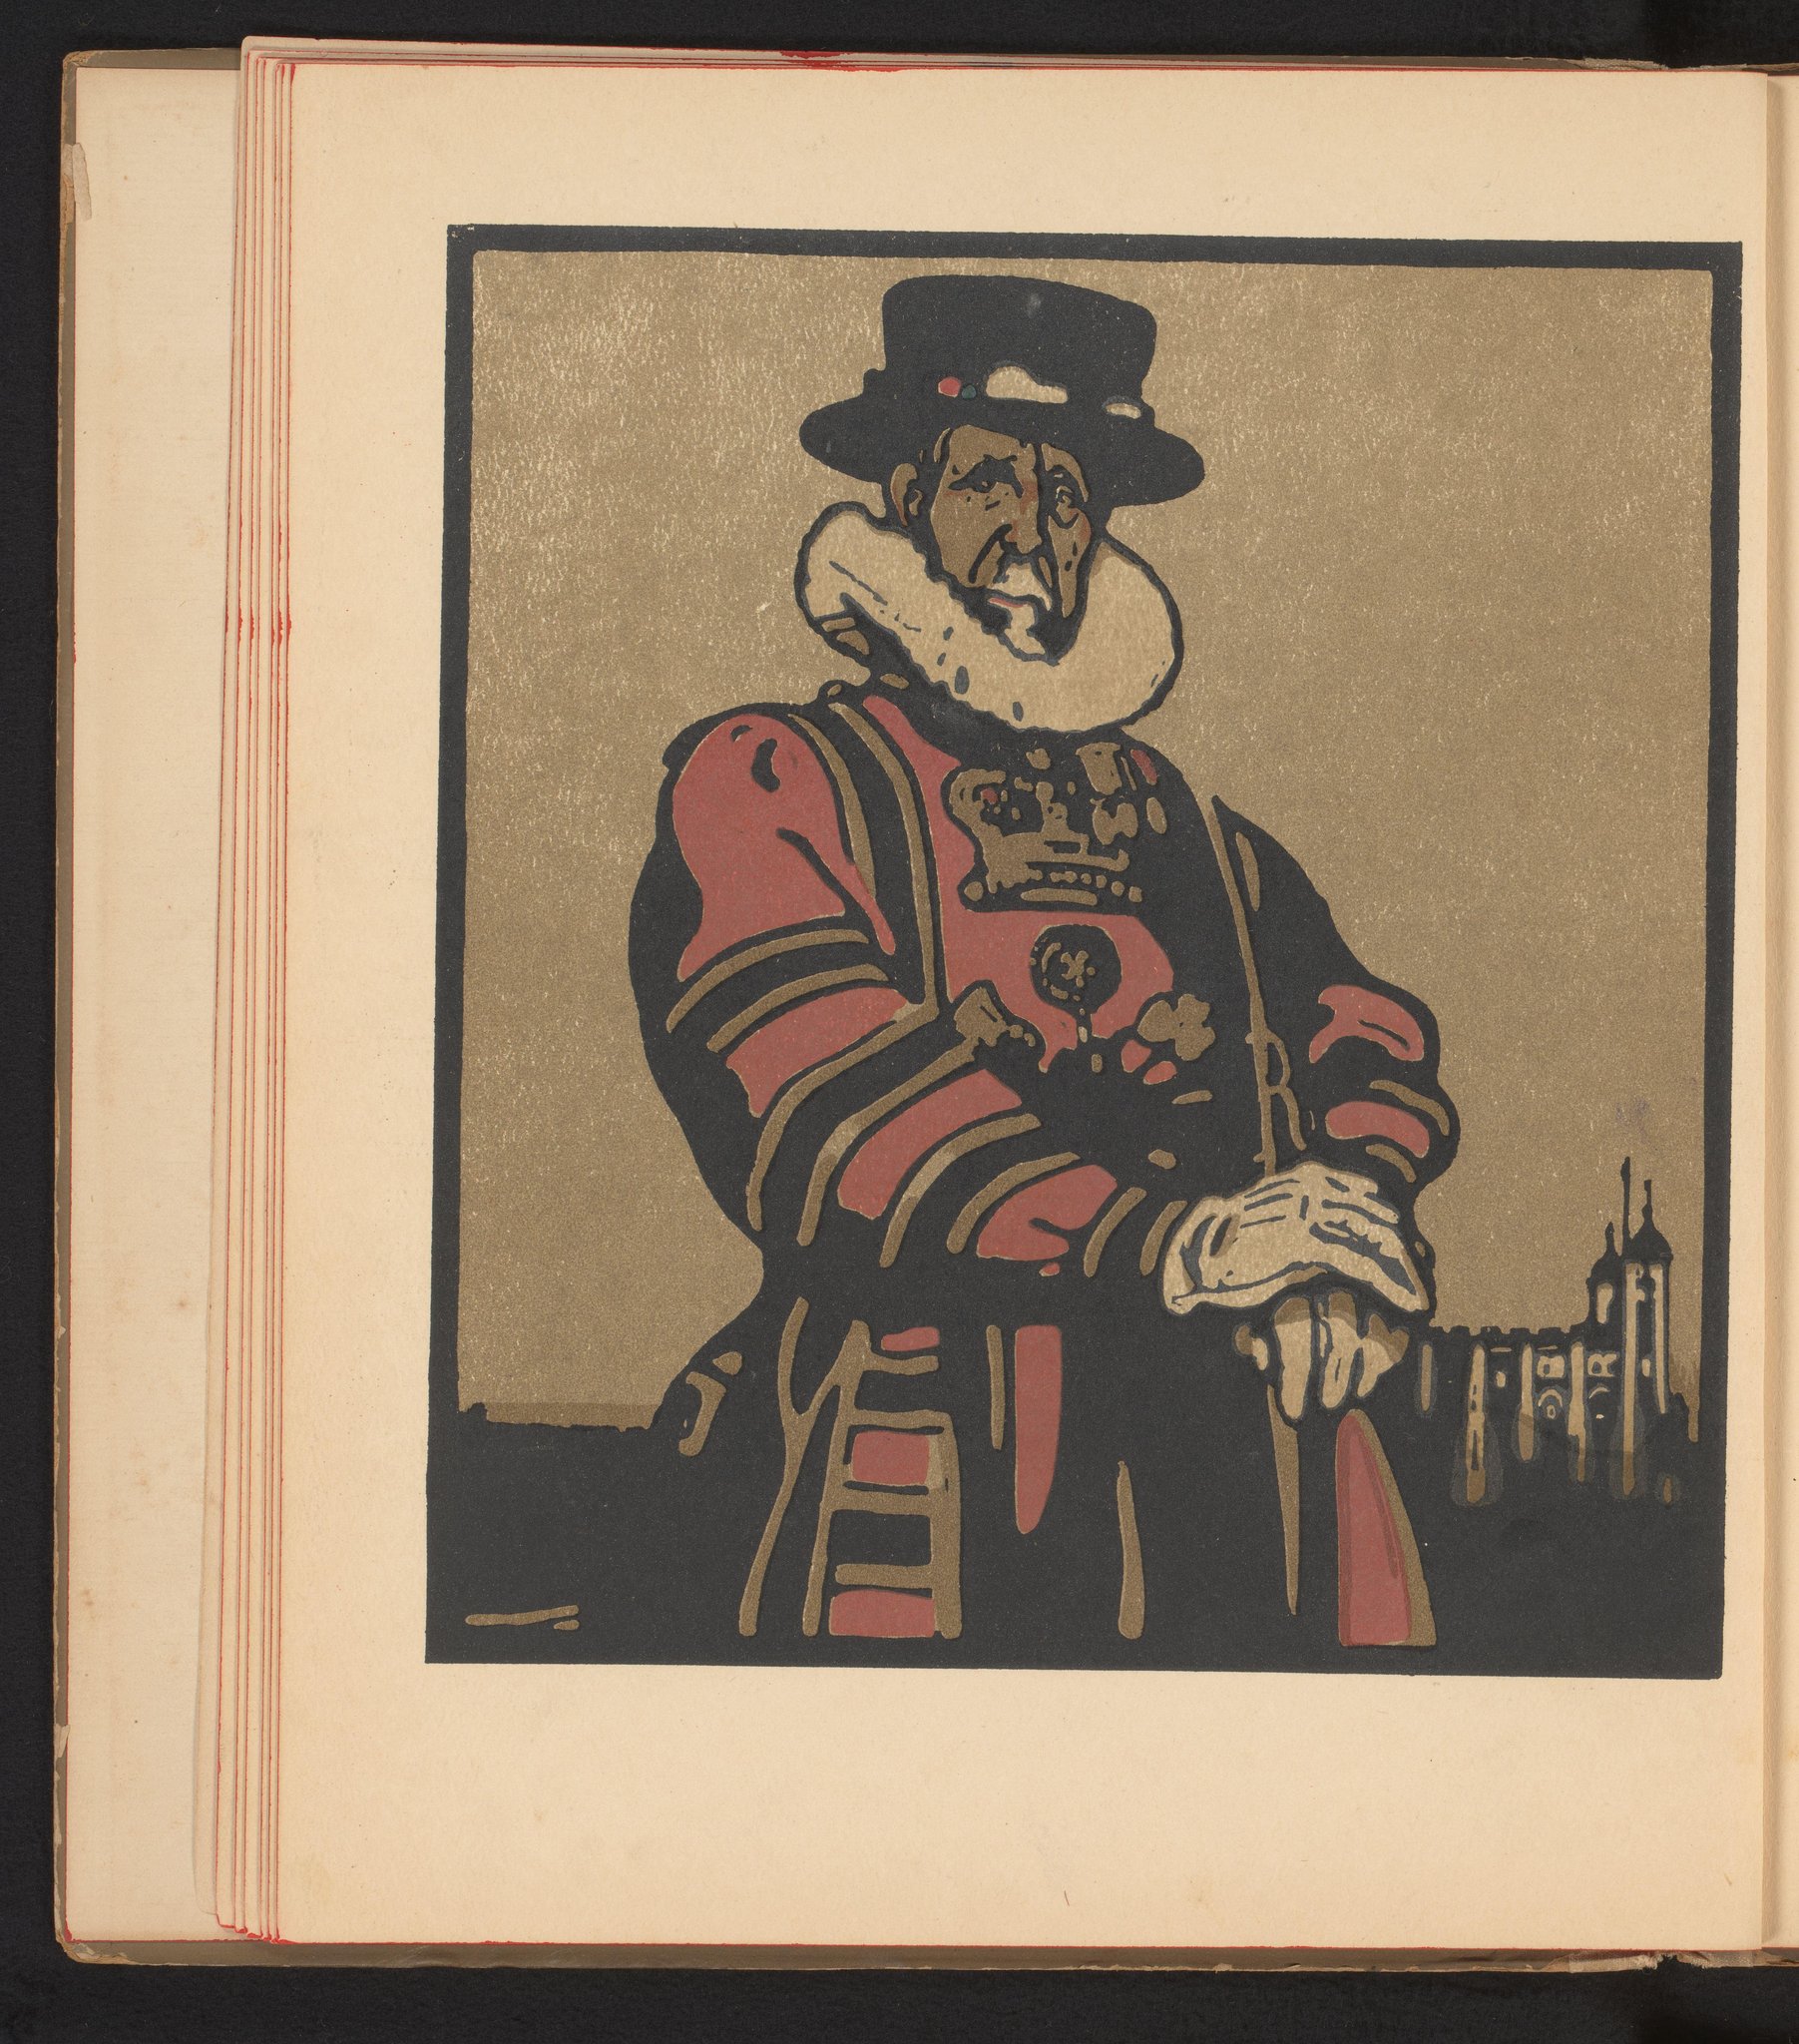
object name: print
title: Yeomen of the Guard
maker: william ernest henley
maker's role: criticus, dichter, redacteur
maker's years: 1849-1903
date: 1898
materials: paper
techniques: lithograph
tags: guard of honour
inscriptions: date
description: Lithografieën naar ontwerpen van houtsneden door William Nicholson. Sonnet in het Engels op de tegenoverliggende bladzijde.